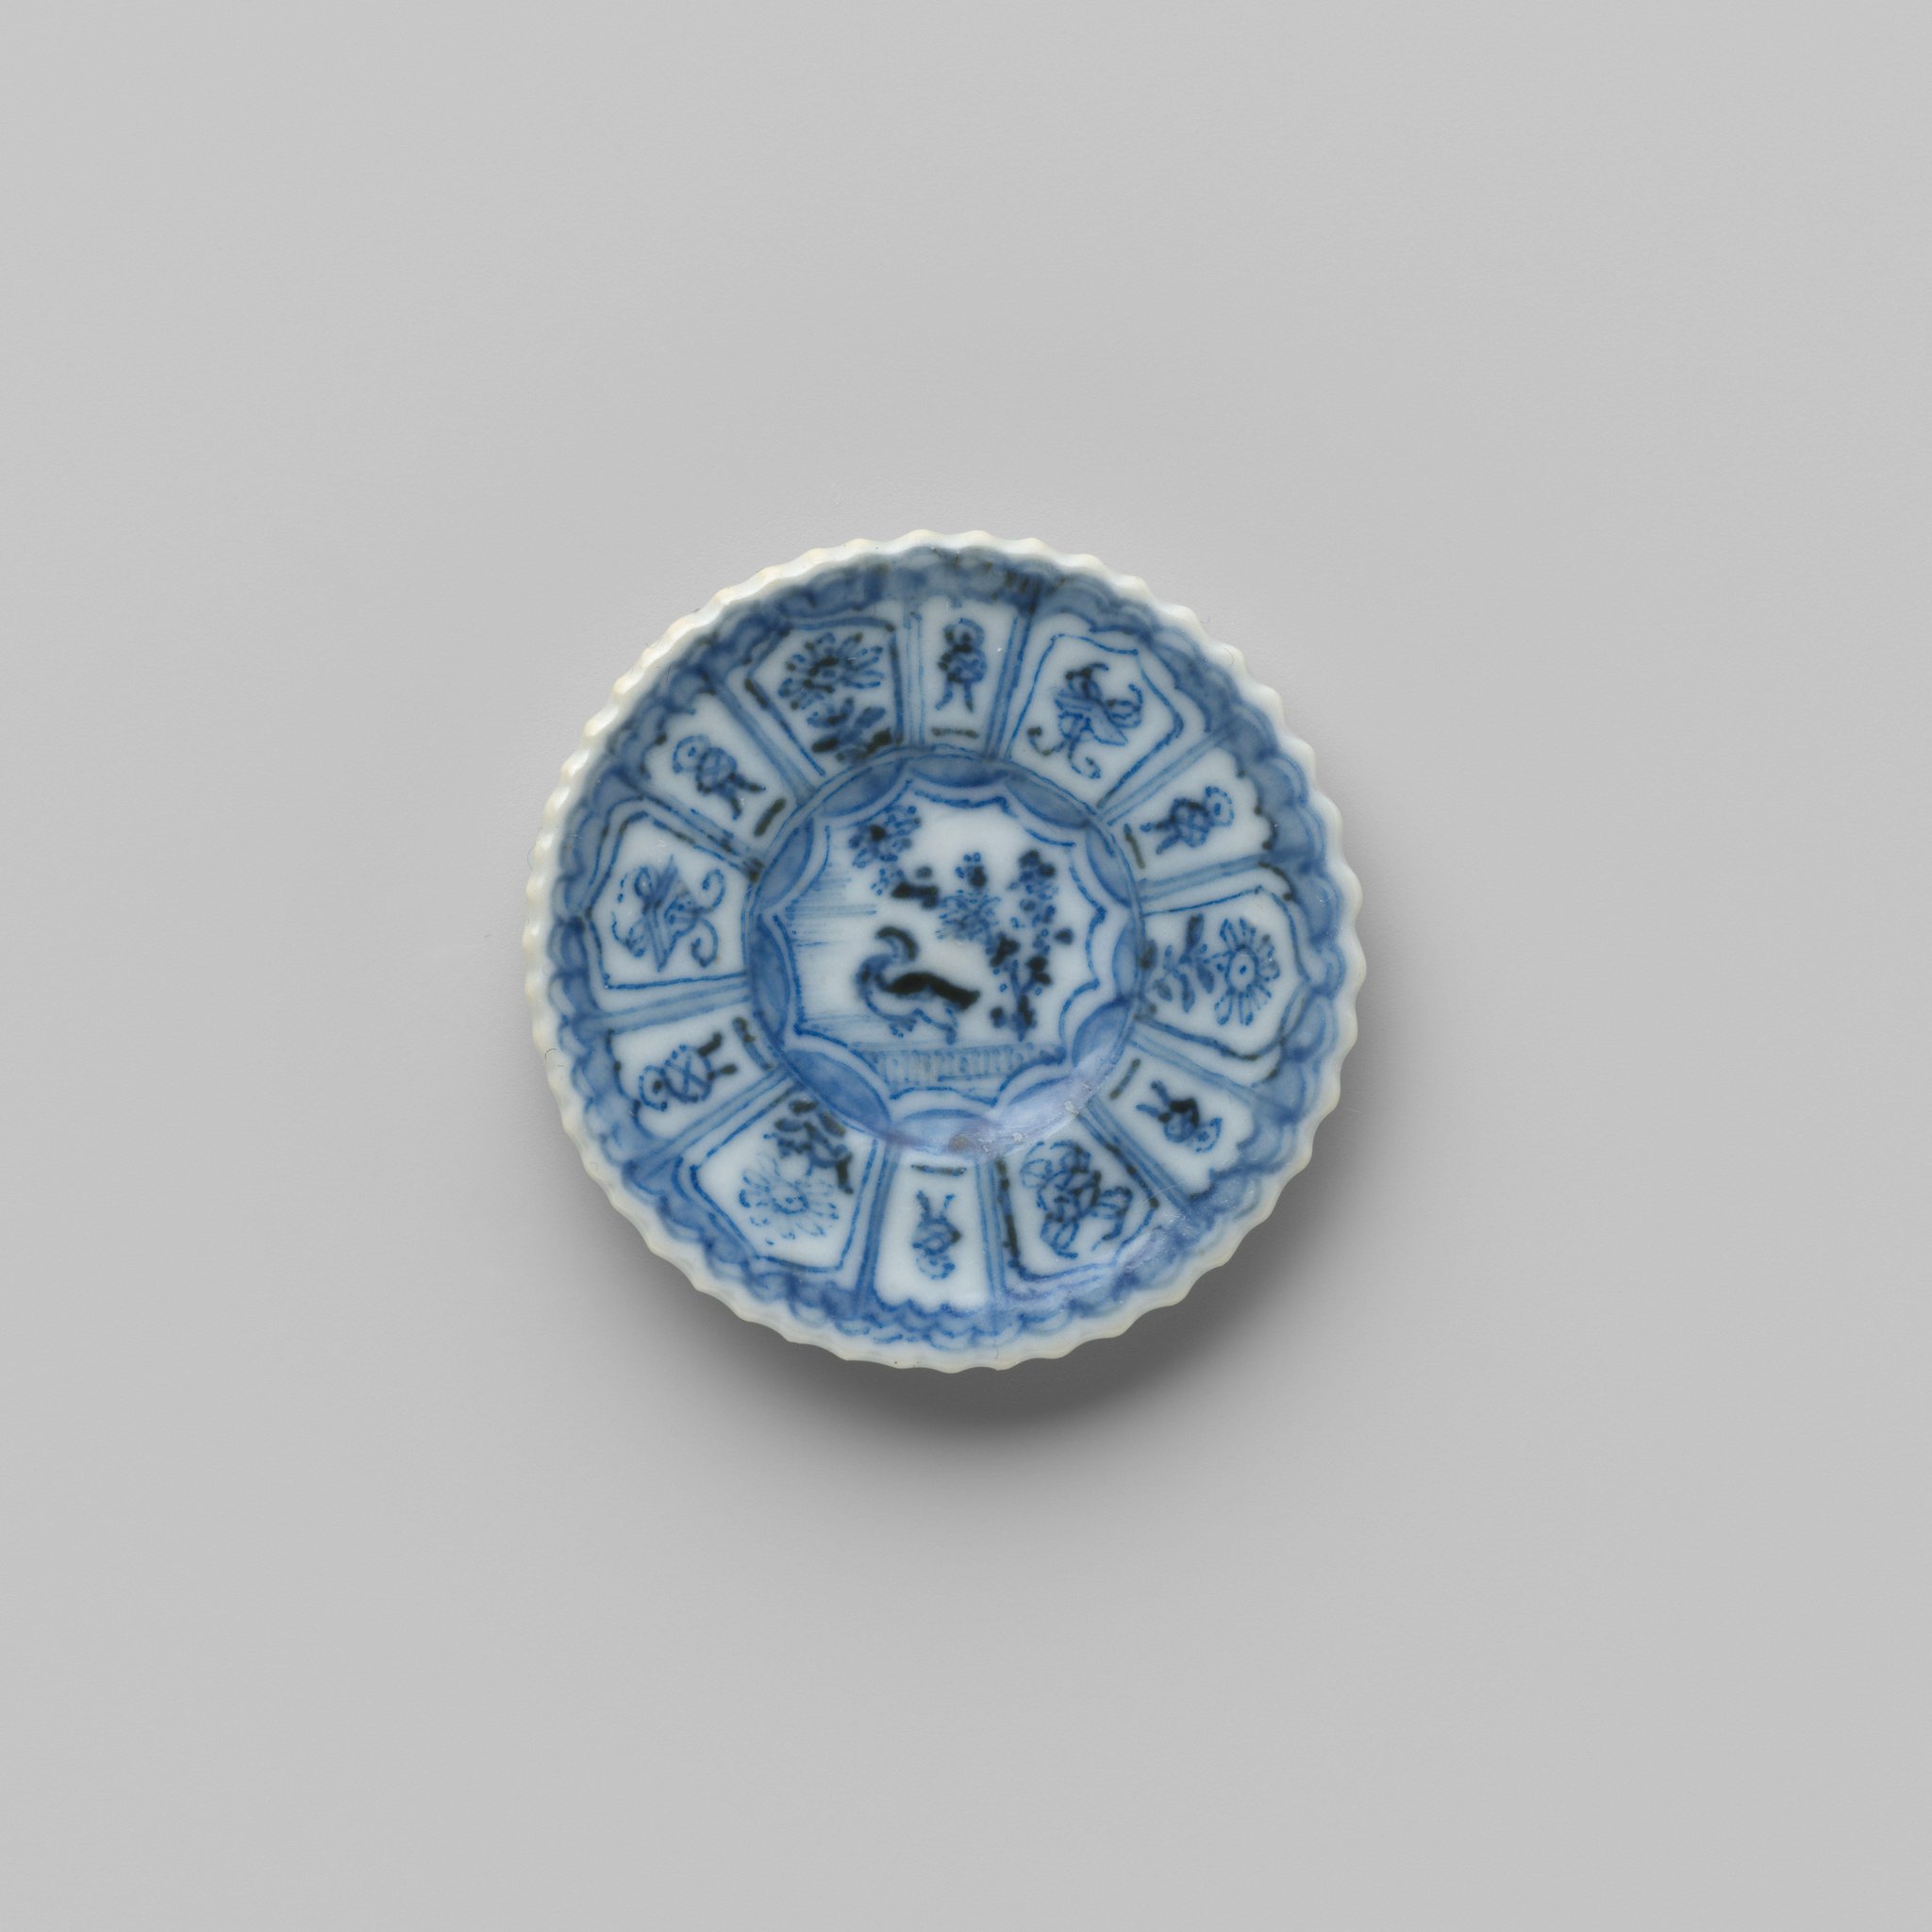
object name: miniature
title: Bord van porselein met blauwe onderglazuur decoratie in 'Kraak' Wanli stijl; plat met vogel (eend) onder boom aan oever, eveneens op achterzijde versierd.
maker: Anonymous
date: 1675-1715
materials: porcelain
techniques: painted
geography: china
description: Bord op voetring, met schulprand. Gedecoreerd in onderglazuur blauw in de stijl van Kraakporselein, met een eend op de rivieroever en bloeiende planten. De wanden zijn verdeeld in brede en smalle velden, deze zijn gevuld met bloemen, vlinders en symbolen. De achterzijde van de wand is beschilderd met grote panelen gevuld met bloeiende takken. Zie BK-NM-1010-112-A.